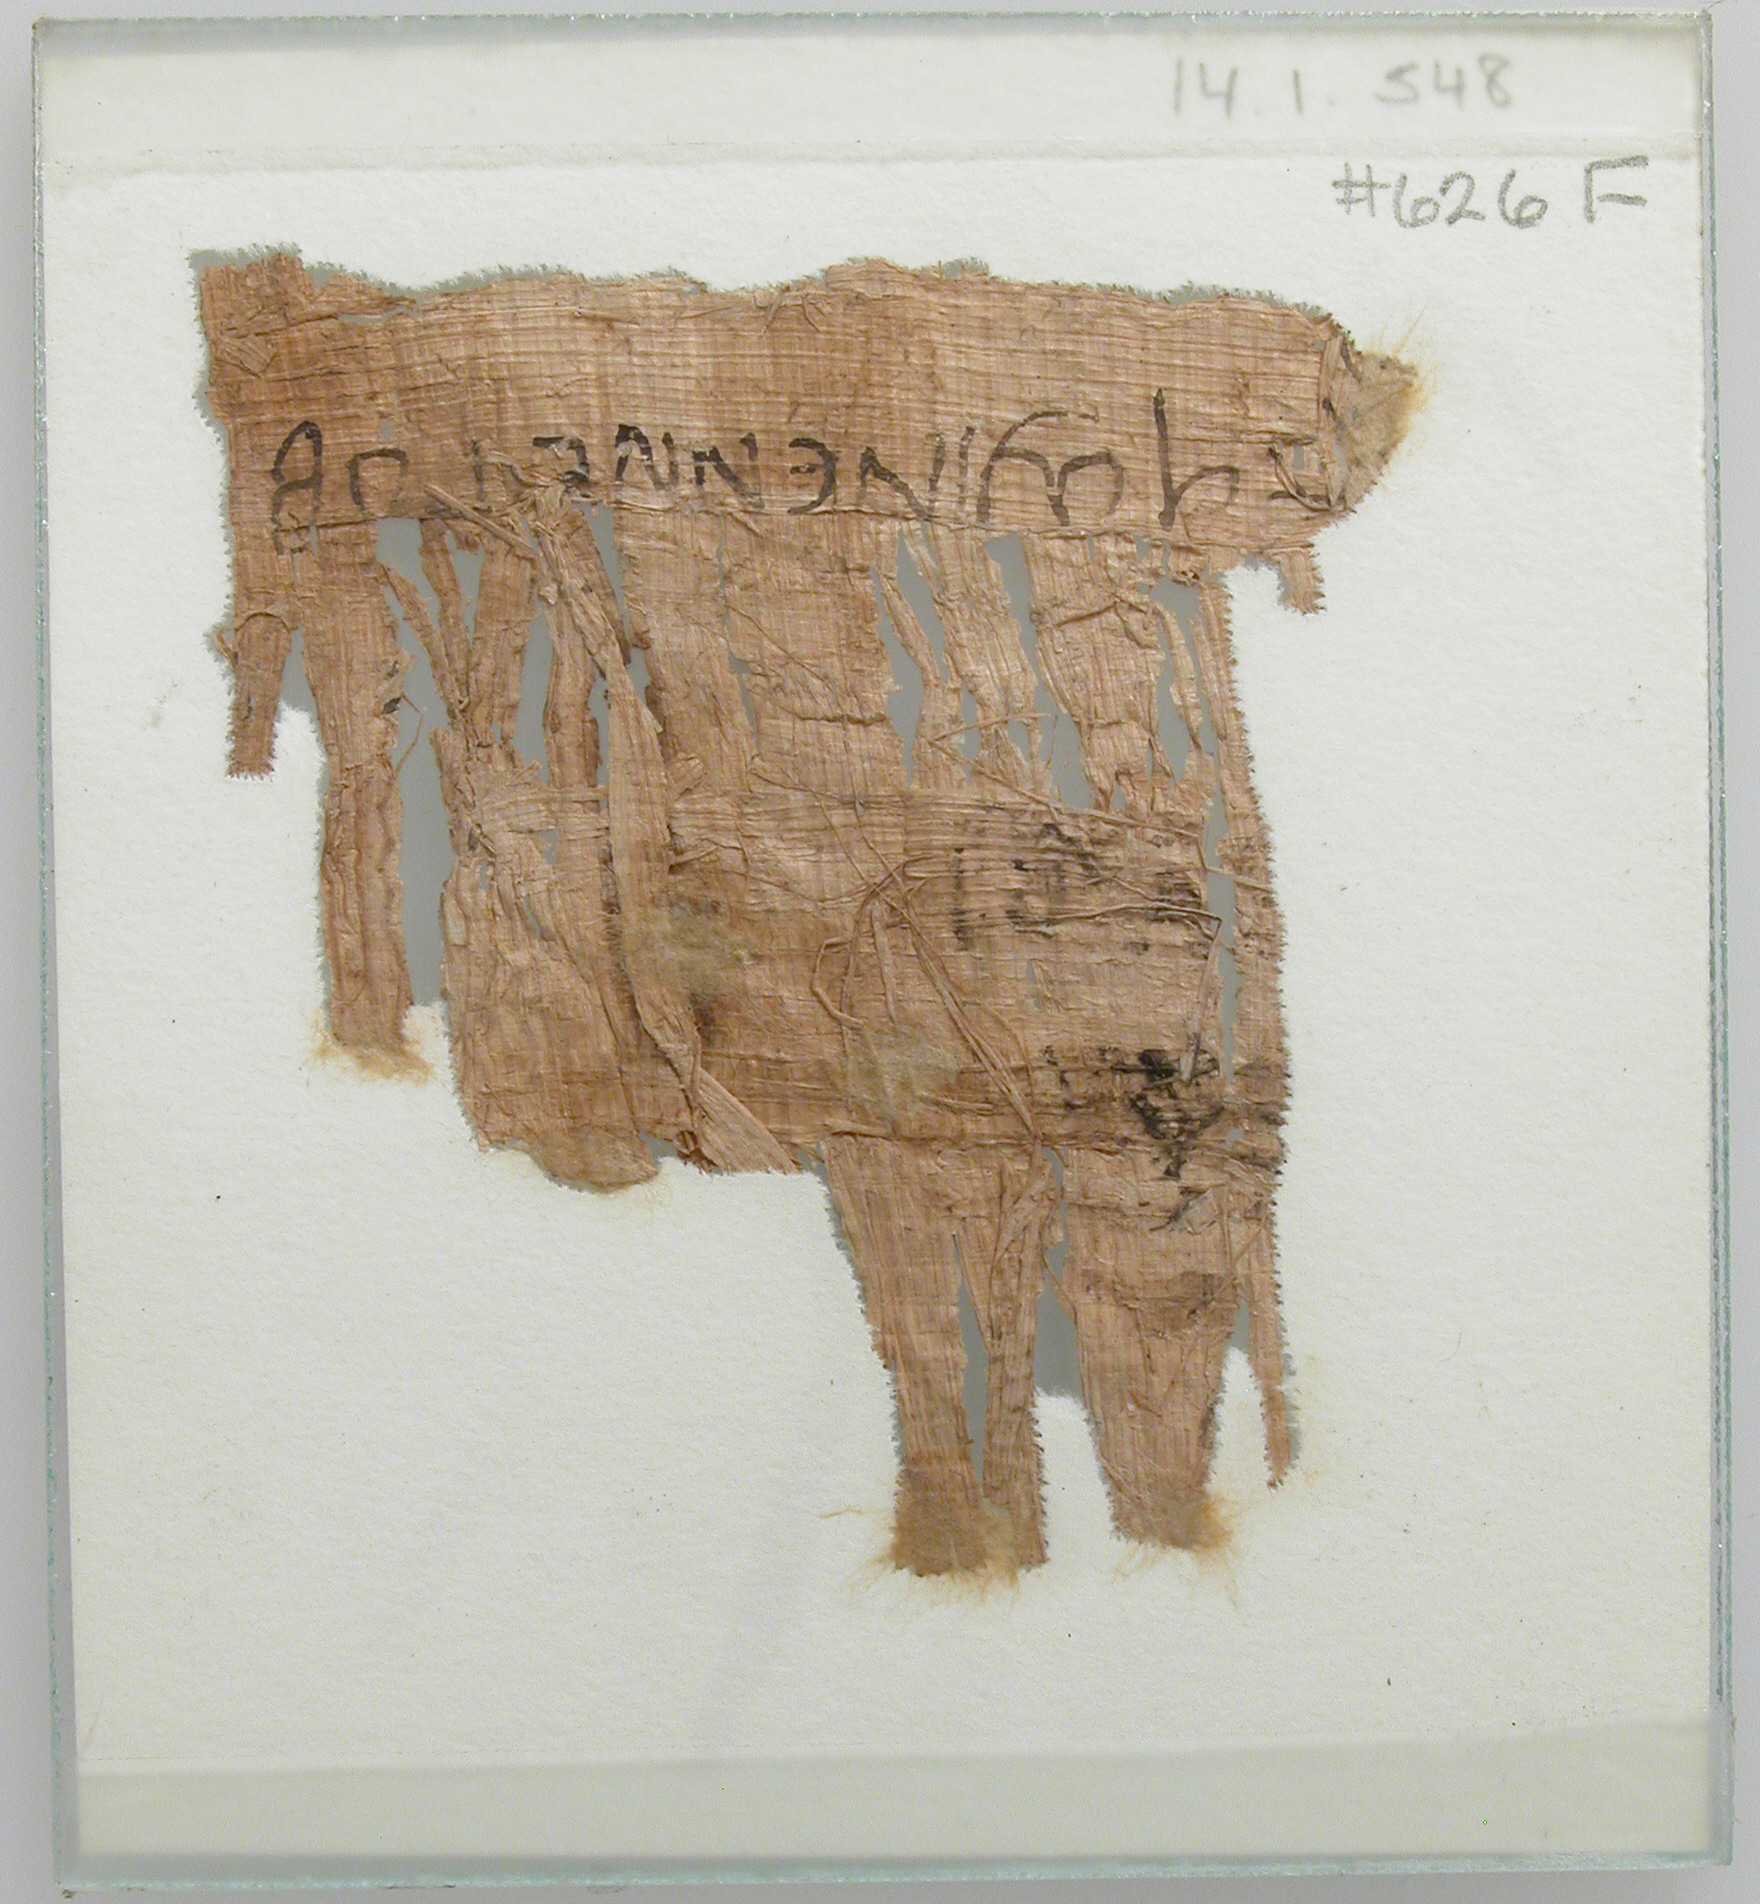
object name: fragment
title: Papyrus Fragment of a Letter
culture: coptic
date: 600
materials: ink, papyrus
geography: egypt